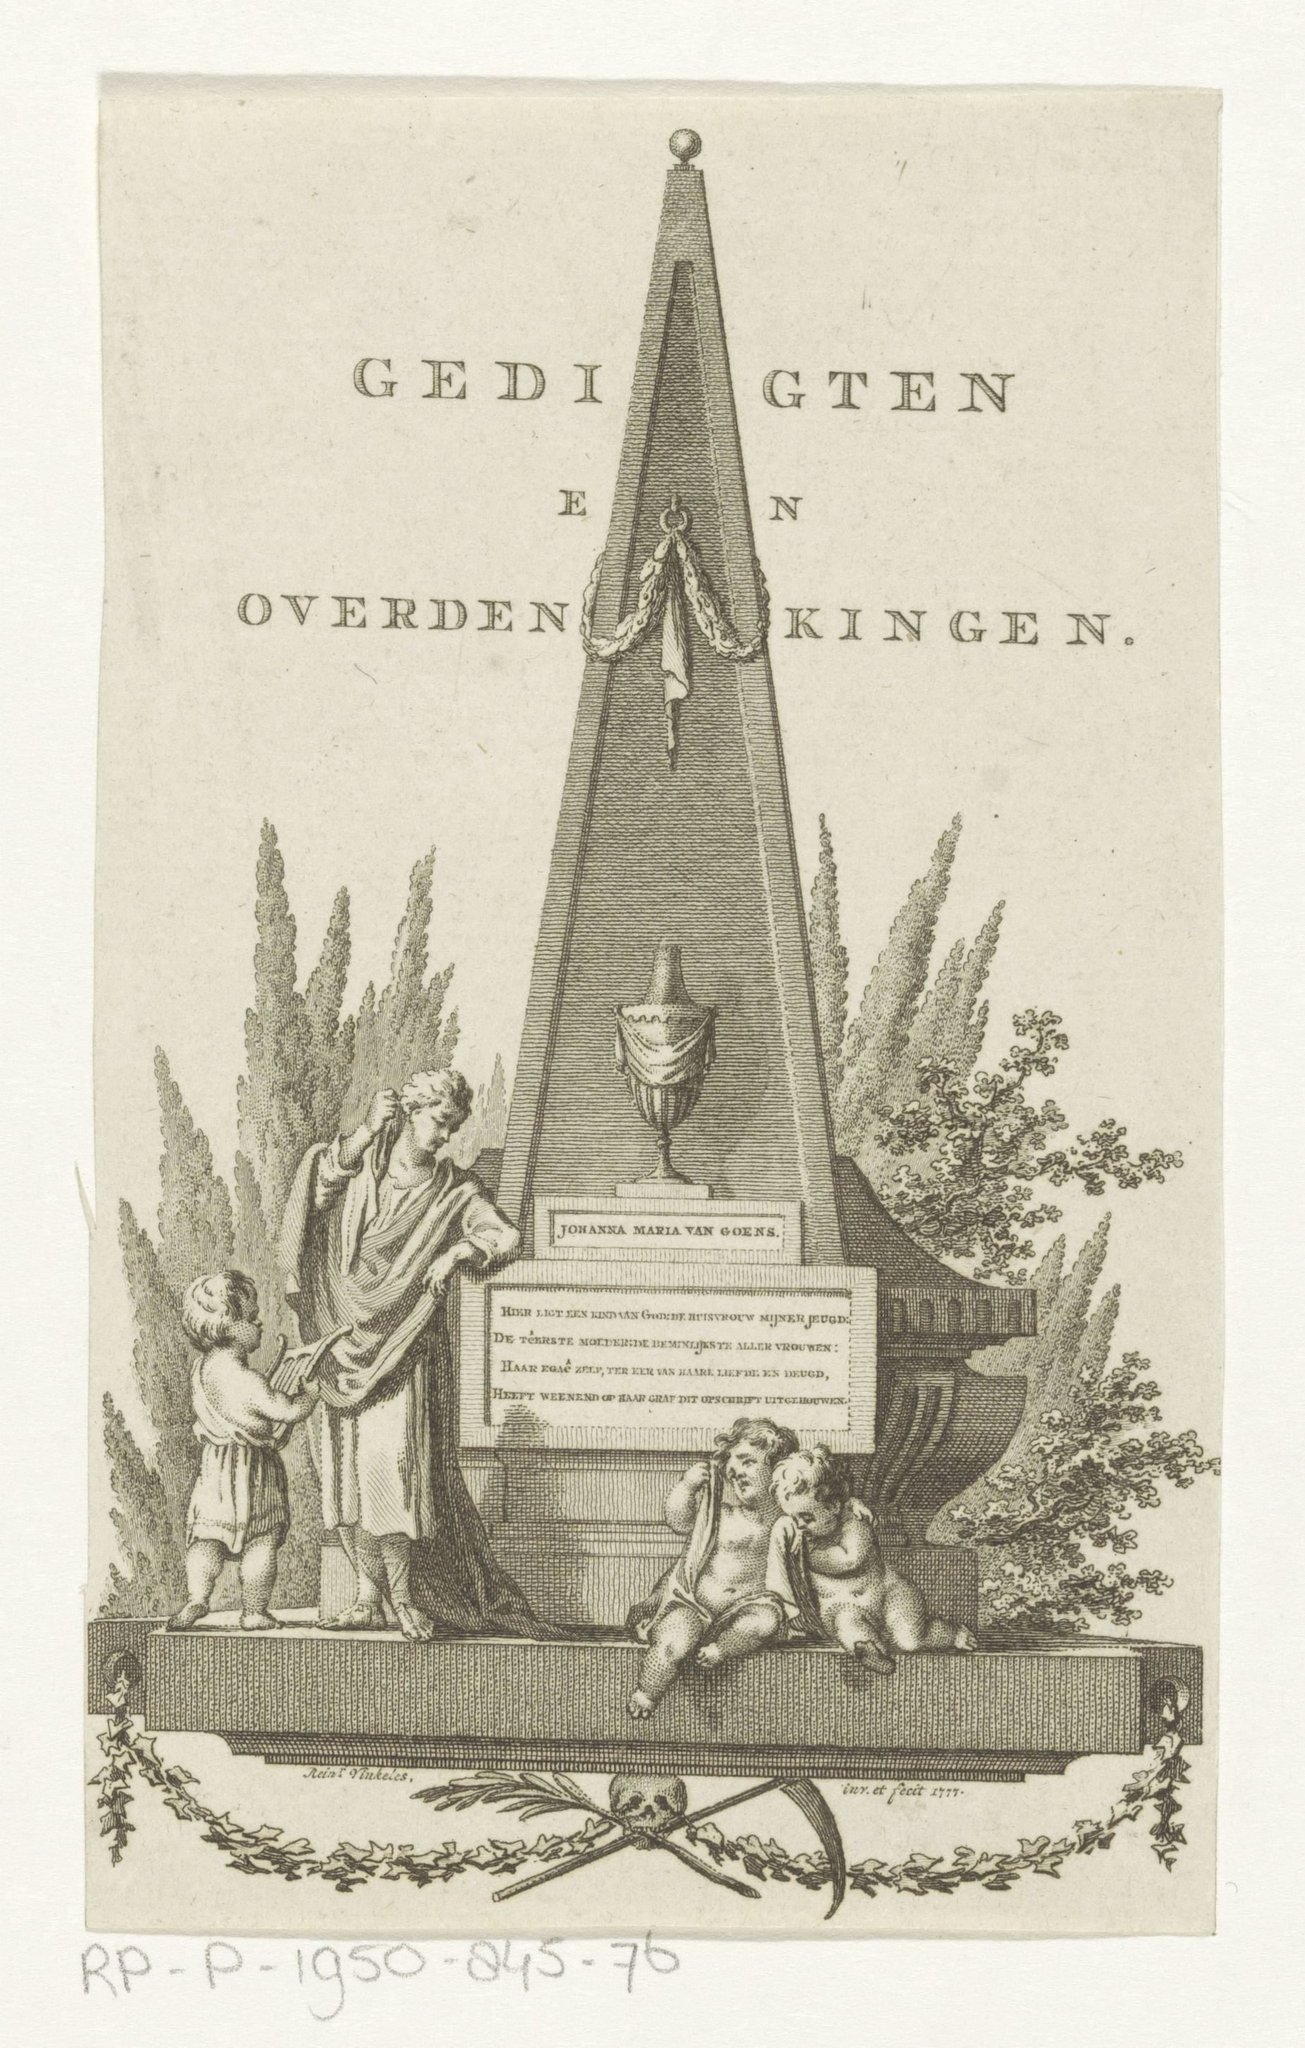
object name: print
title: Titelpagina voor: Hiëronimus van Alphen, Gedigten en Overdenkingen, 1777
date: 1777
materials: paper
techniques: engraving, etching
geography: utrecht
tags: mourning the dead, needle, obelisk (marking grave)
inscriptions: collector's mark: Lugt 2228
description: Titelpagina voor: Alphen, Hiëronimus van. Gedigten en Overdenkingen. Utrecht: Terveen, Jan van, 1777. Prent afkomstig uit een plakalbum met titelprenten, ornamenten etc. op blauw papier in 1983 uit elkaar gehaald. Volgens een notitie op verso zat de prent op p. 76 van dit album.